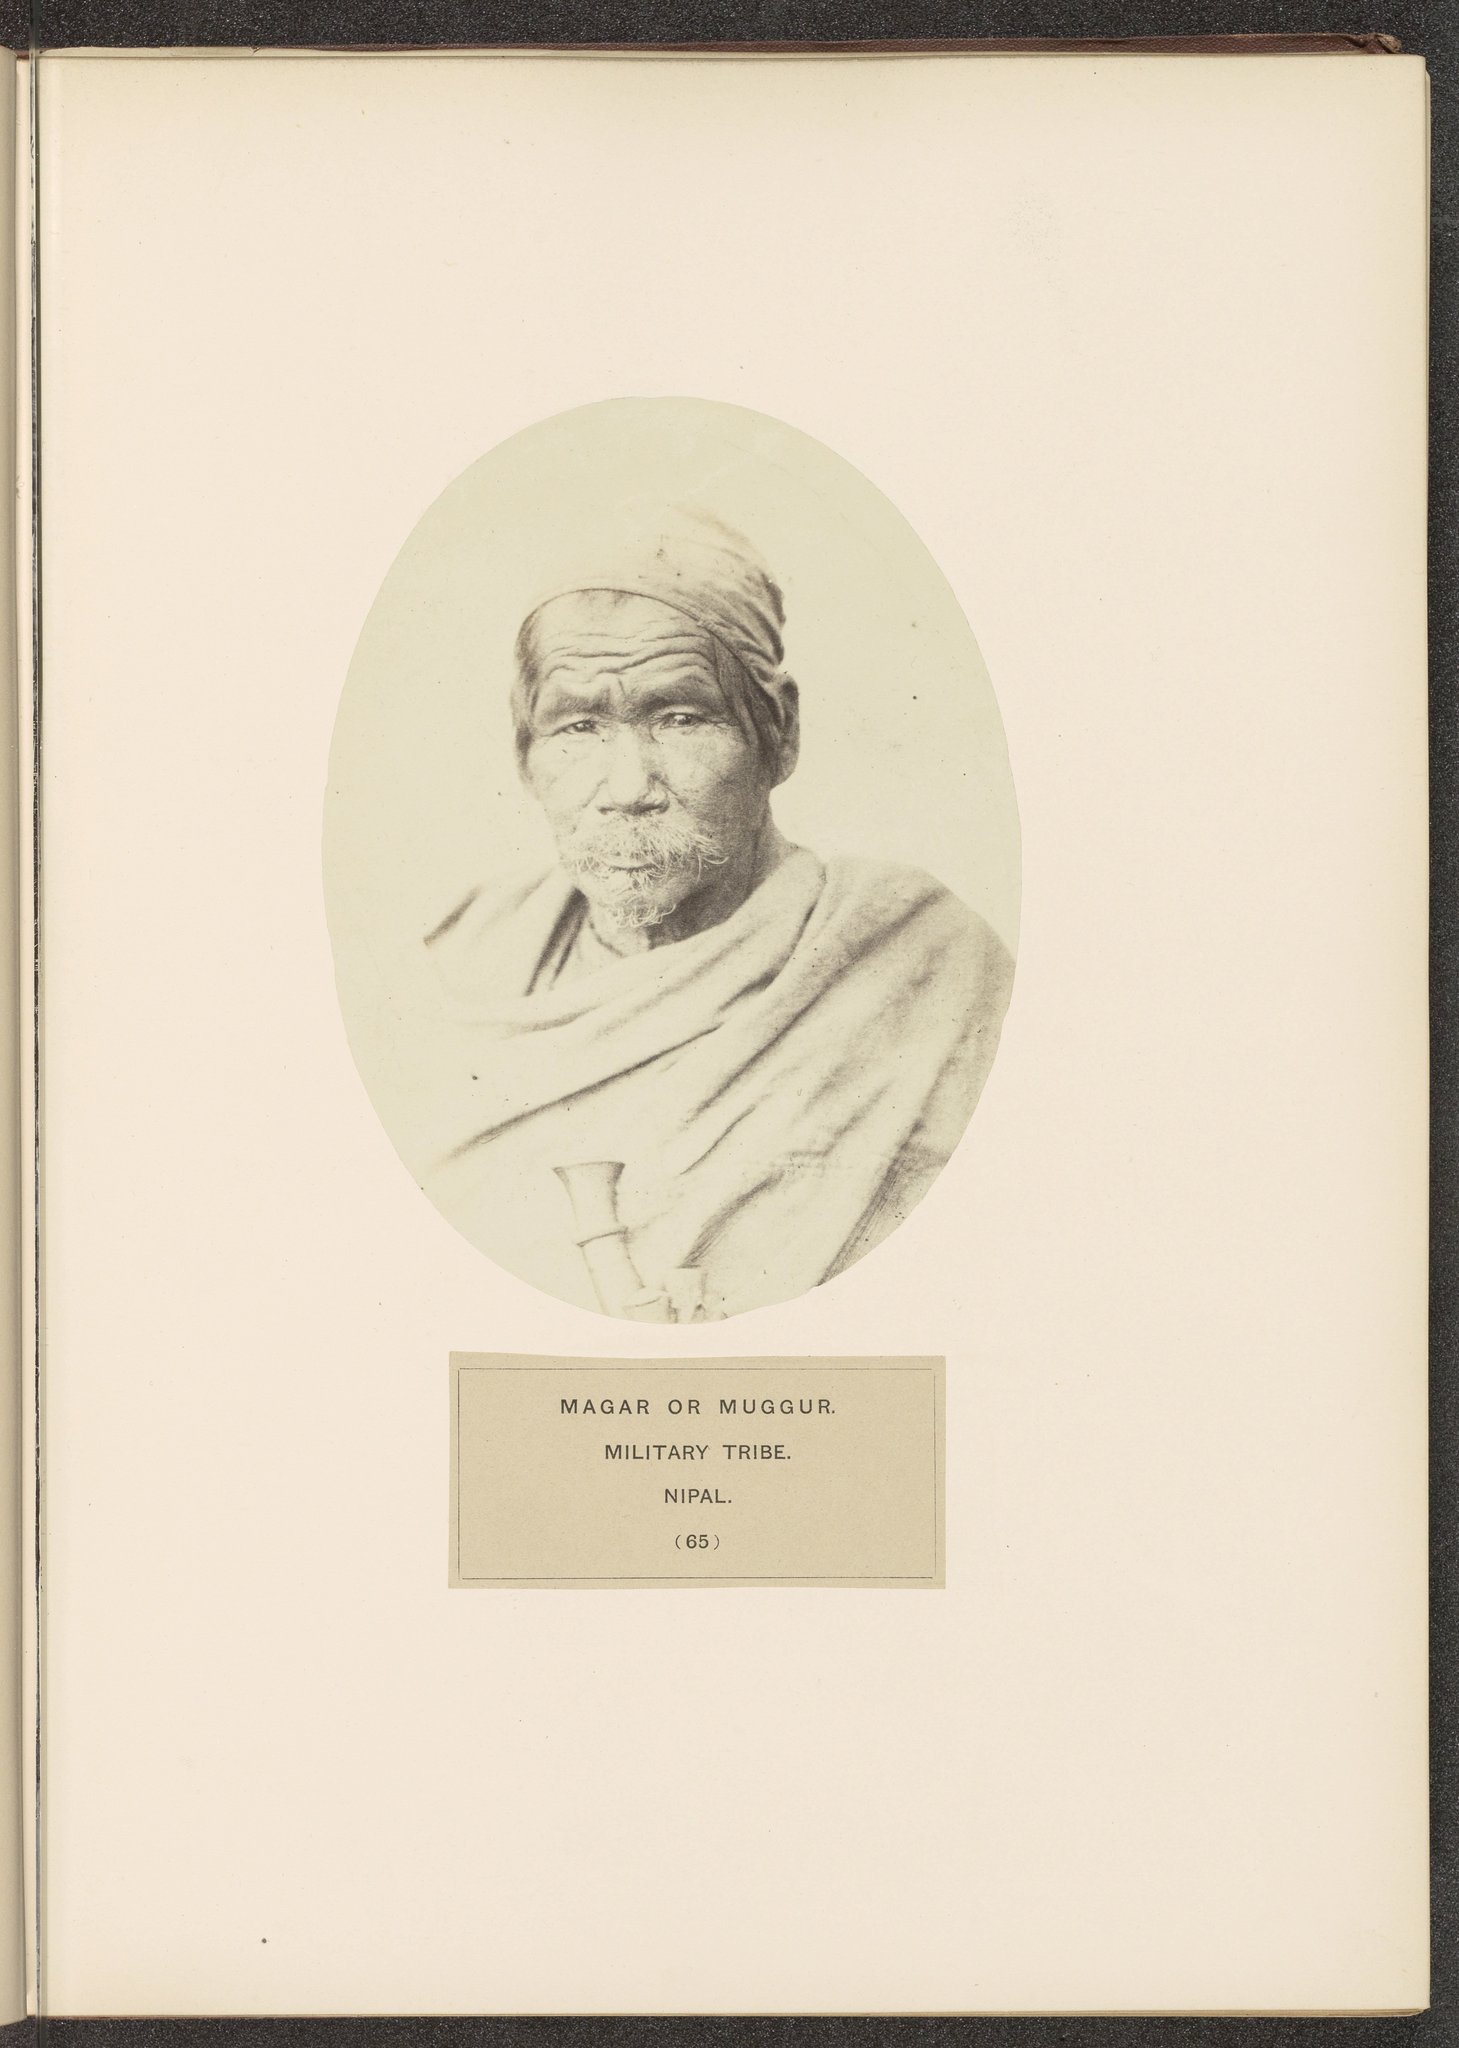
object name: photograph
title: Portrait of an unknown man from the Magar community of Nepal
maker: benjamin simpson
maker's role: fotograaf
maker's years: 1831-1923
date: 1858-1868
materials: photographic support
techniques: albumen print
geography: nepal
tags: head-gear: hat, human races; peoples; nationalities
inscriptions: number: ‘(65)’, inscription: ‘MAGAR OR MUGGUR./ MILITARY TRIBE./ NIPAL.’